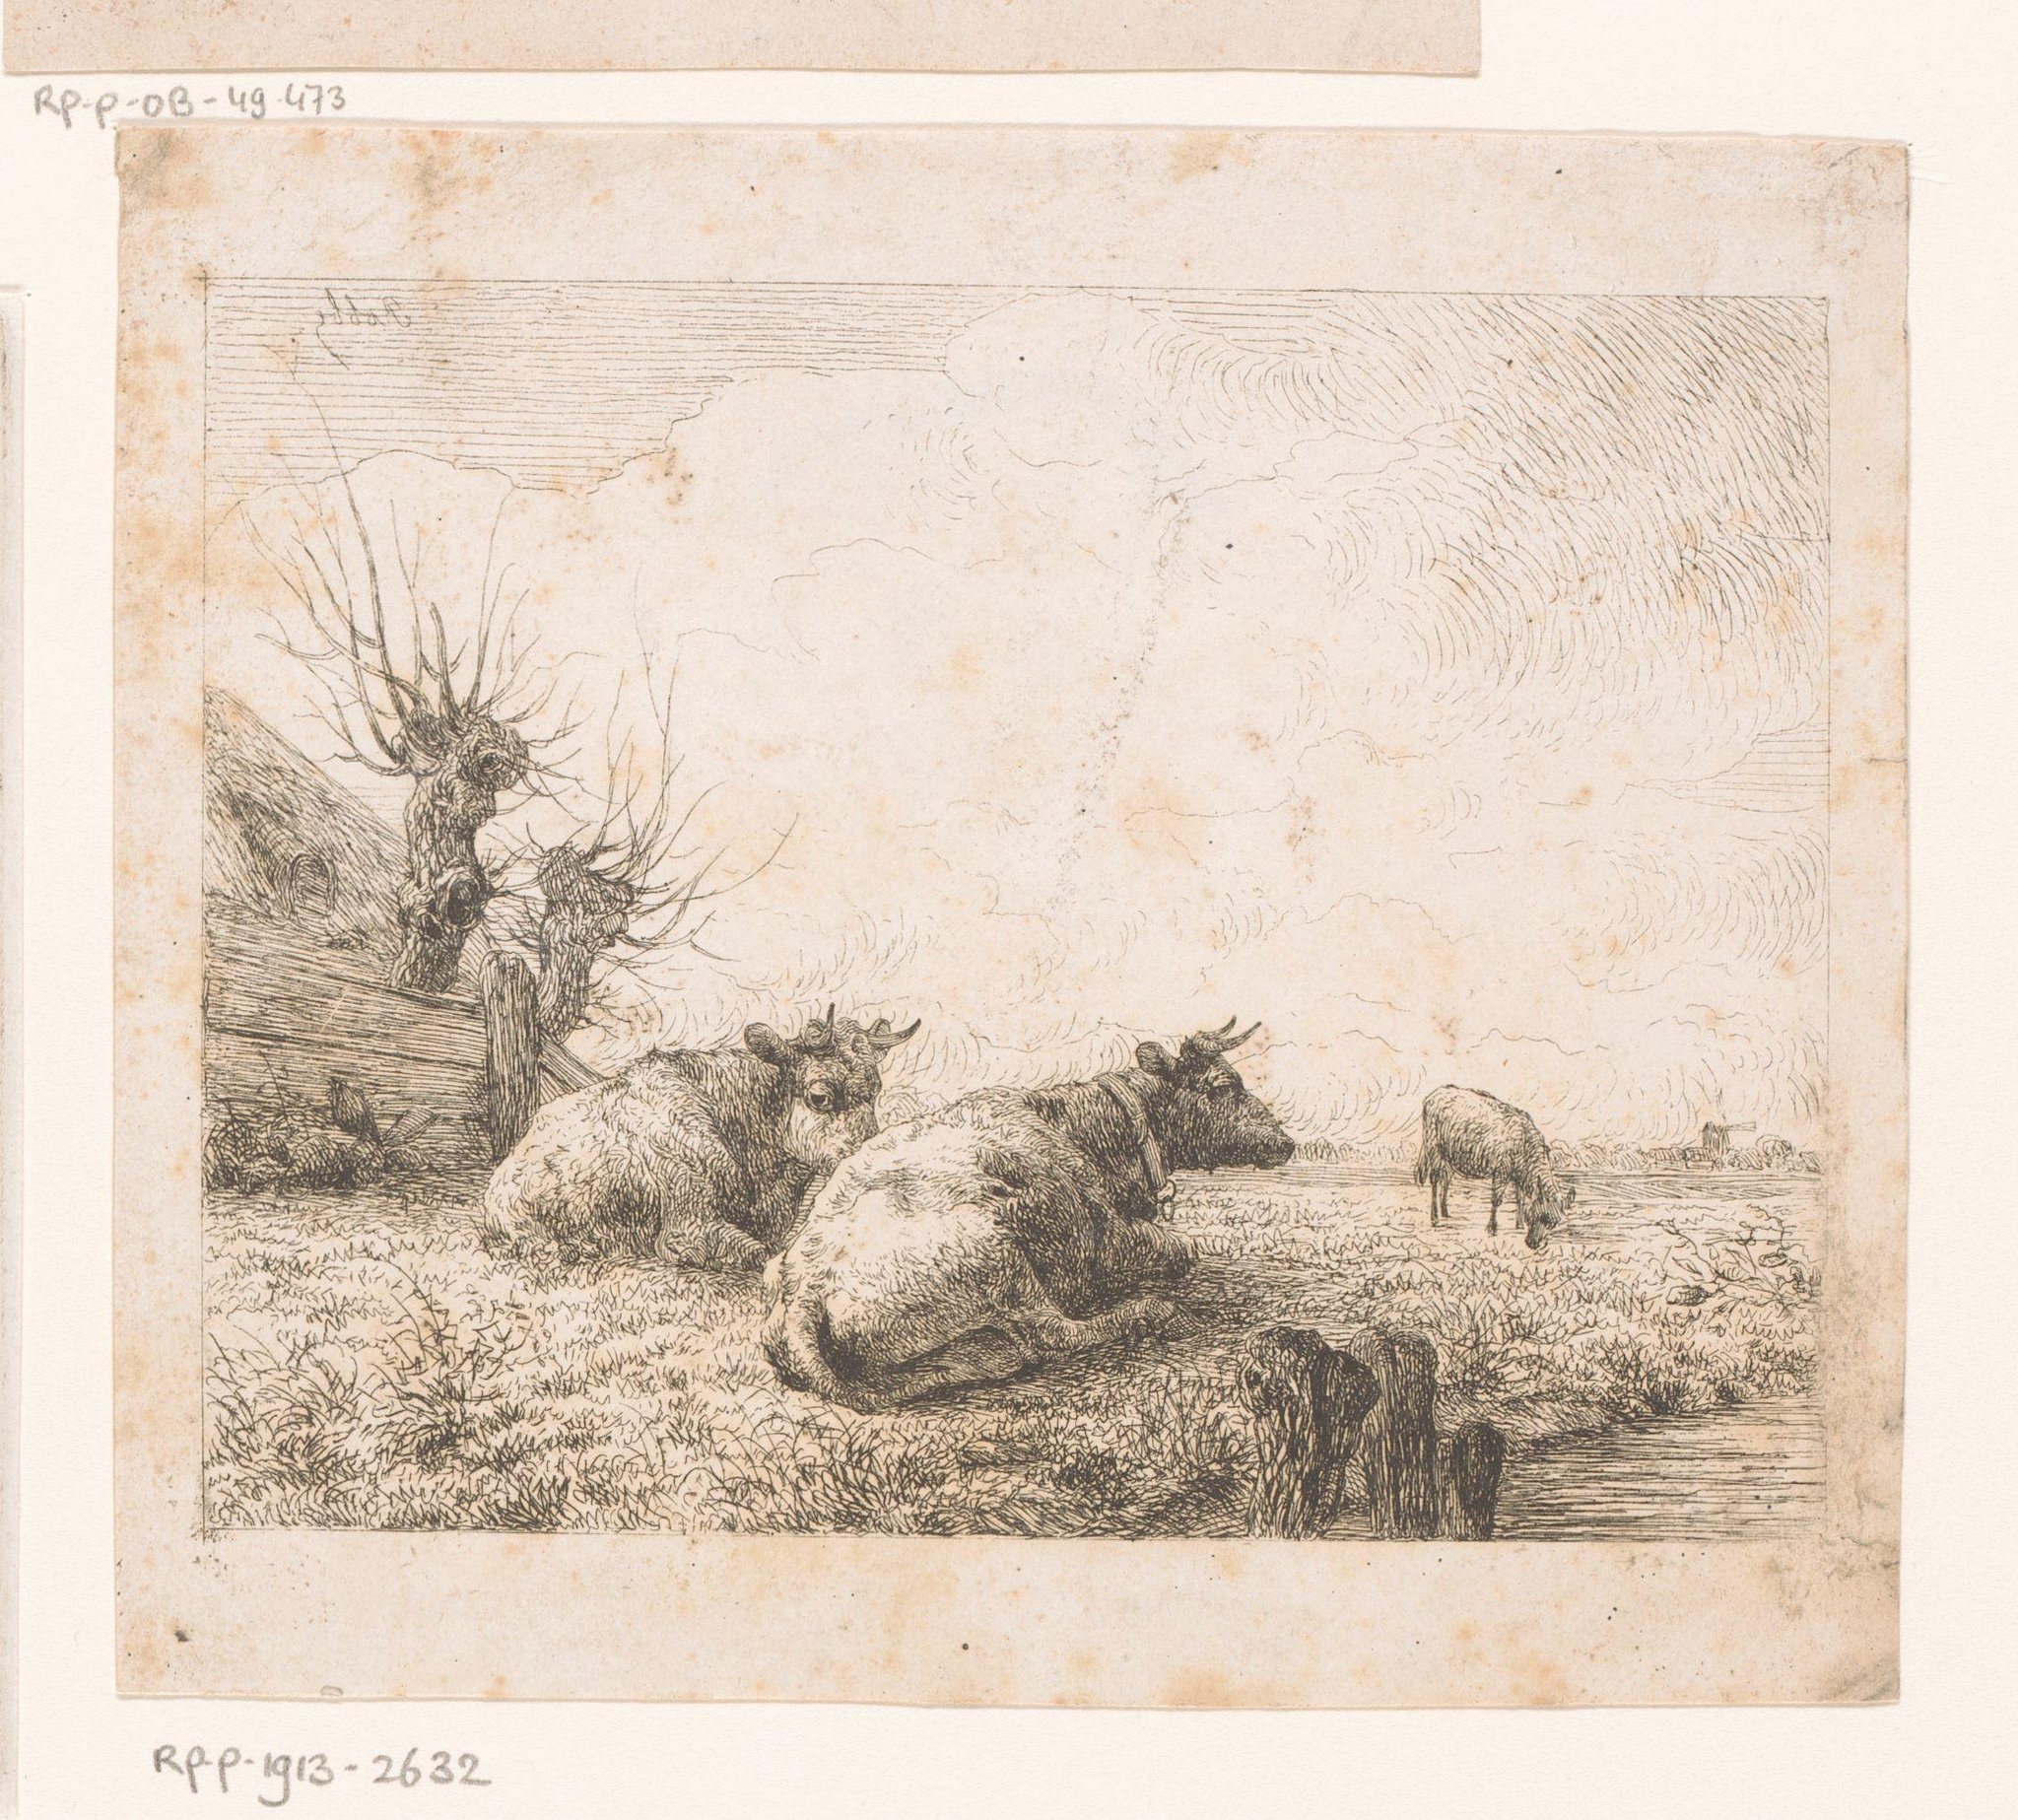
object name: print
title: Landschap met twee koeien liggend bij een omheining met twee knotwilgen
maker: louis robbe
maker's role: print maker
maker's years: 1806-1887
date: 1816-1879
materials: paper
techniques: etching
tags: meadow, pasture, trees: willow, bovine cattle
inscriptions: collector's mark: Lugt 1485, collector's mark: Lugt 2228